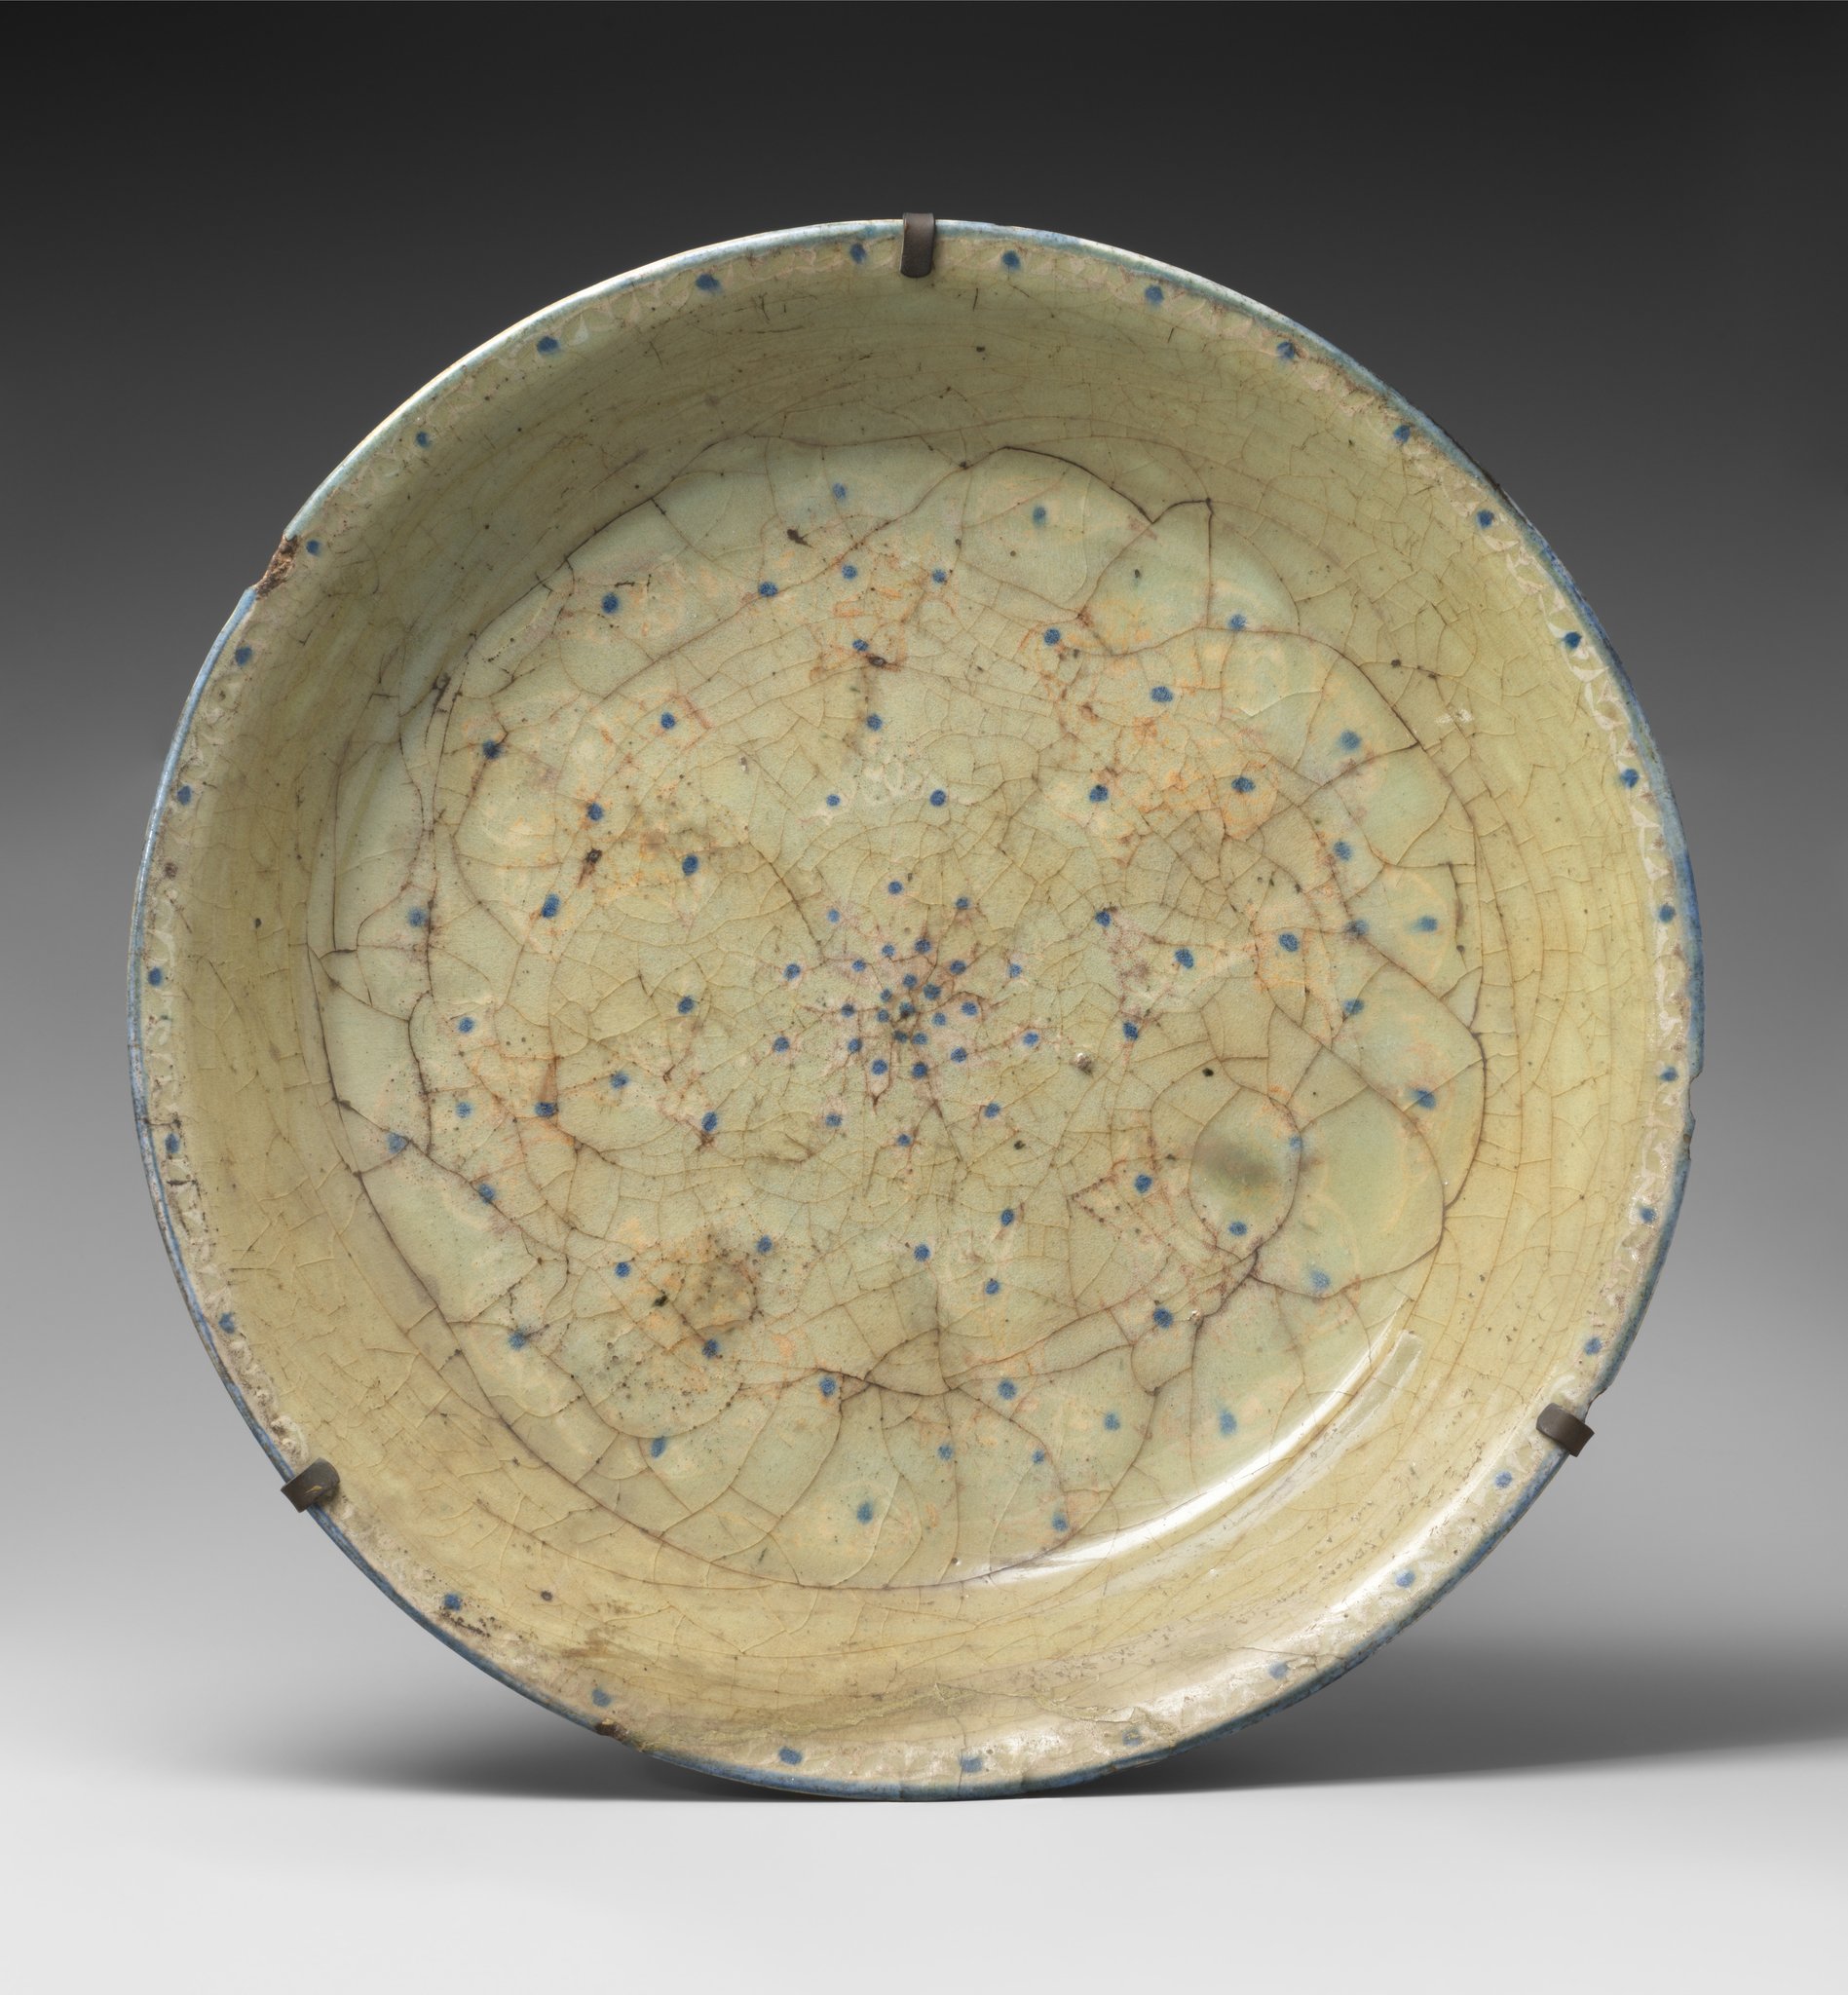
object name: bowl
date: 1701-1800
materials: stonepaste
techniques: glazing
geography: iran